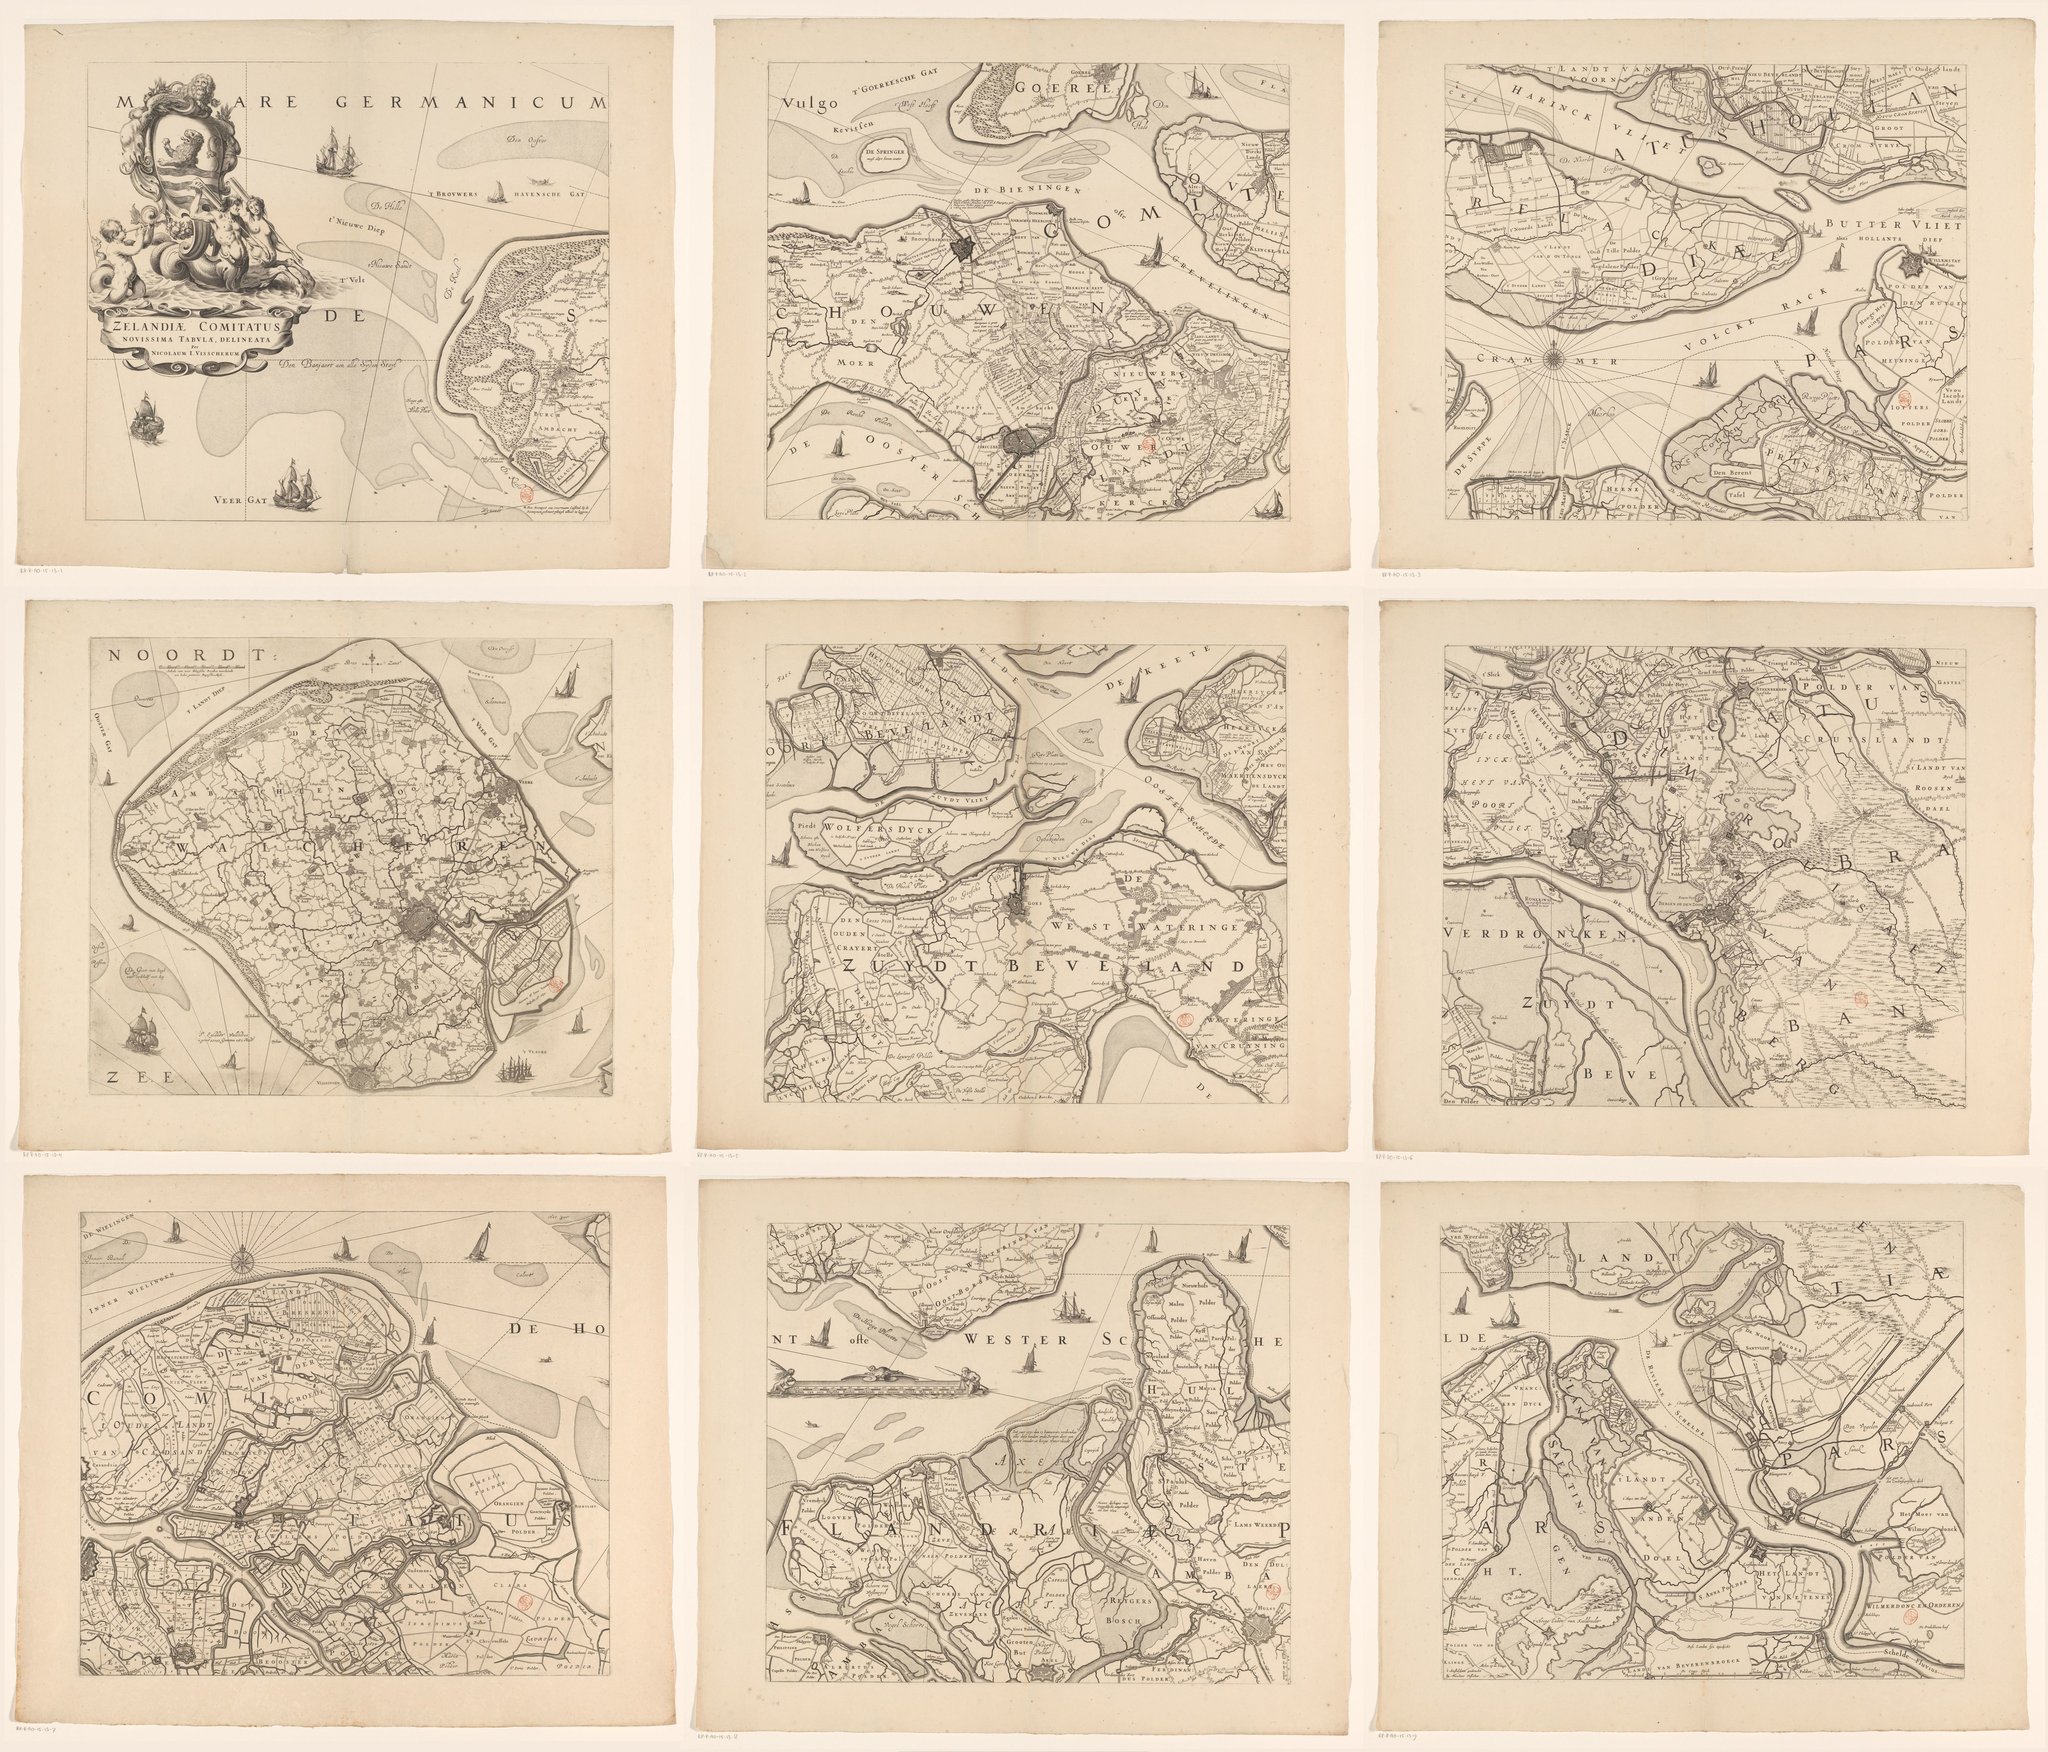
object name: map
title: Zelandiae Comitatus novissima tabula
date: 1655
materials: paper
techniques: engraving, etching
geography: amsterdam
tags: triton(s), maps of separate countries or regions, swimming mammals: seal, coat of arms (as symbol of the state, etc.) (+ province; provincial), ichthyocentaur, centaurotriton, sea-centaur, fisherman, instruments used in geodesy, surveying instruments, zeeland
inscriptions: collector's mark: Lugt 195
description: Linksboven het wapen van Zeeland gedragen door een triton en een vrouwelijke ichthyocentaur, links daarvan een triton met bazuin en daaronder de titel. Links, boven het eiland Walcheren een kleine schaalstok: Schale van 1000 Bloysche roeden maeckende een halve gemeene Duytsche mijle. Onder in het midden, in de Westerschelde, een grote schaalstok met daarop links een vrouwfiguur, in het midden een zeehond en rechts een visser met een hengel en een passer: Schale van 2000 Bloysche roeden, maeckende een gemeene Duytsche myle, van 15 in een graedt.